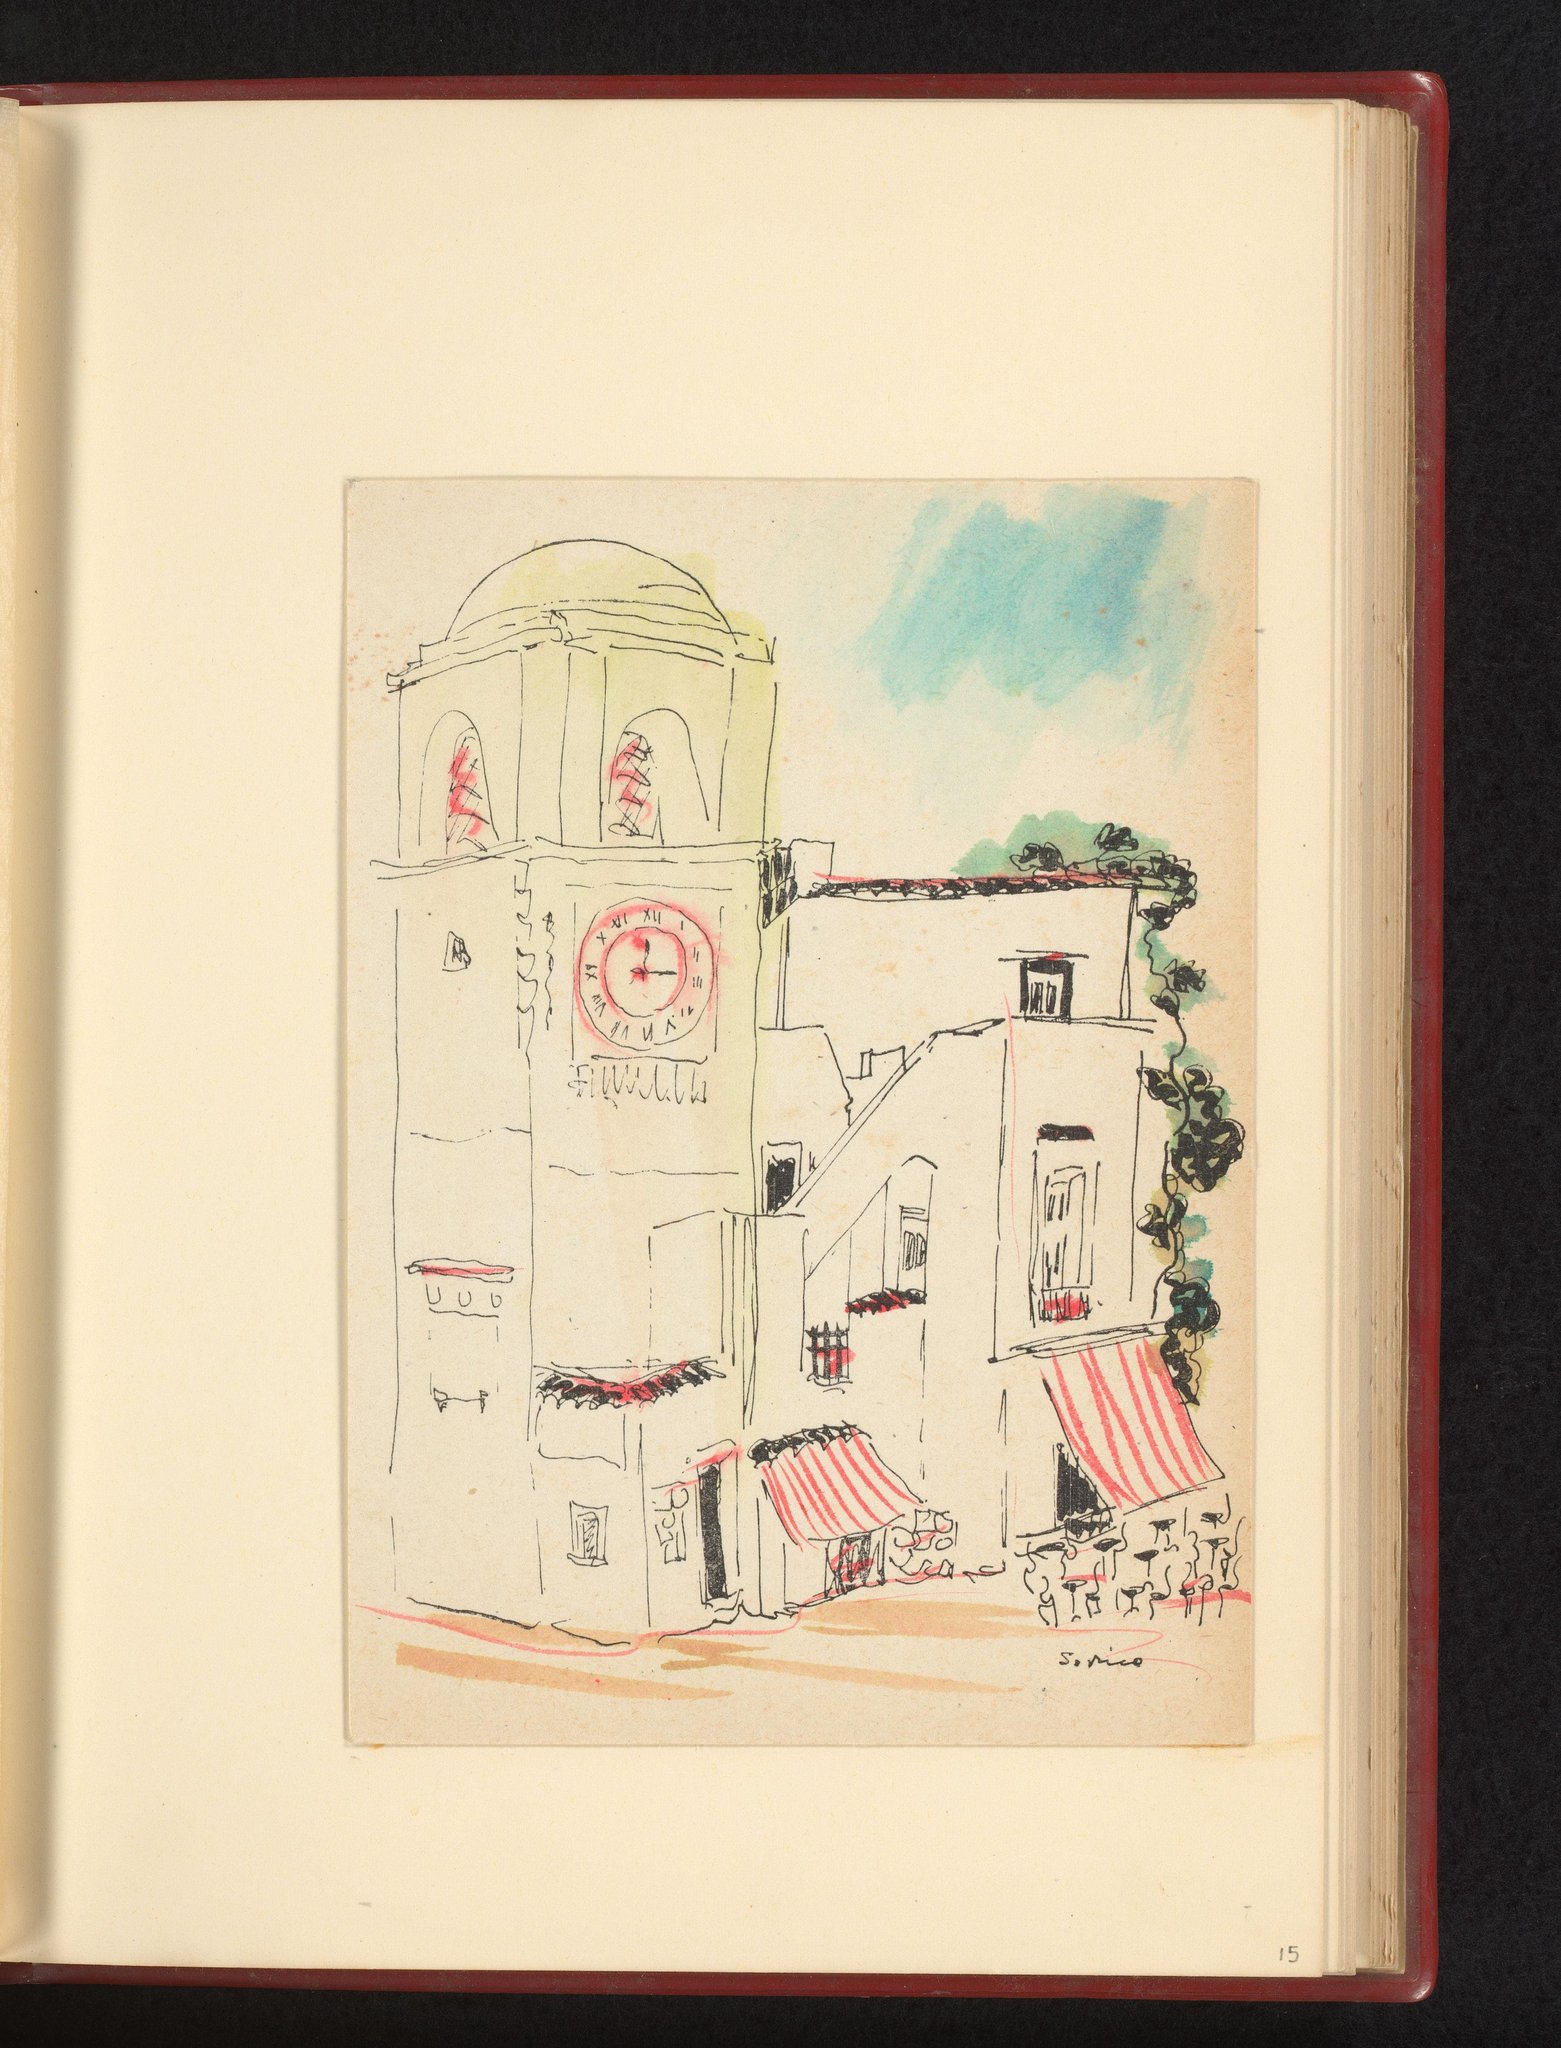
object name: album leaf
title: Fotomechanische afdruk van een tekening van een kerk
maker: Anonymous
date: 1954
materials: paper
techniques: printing block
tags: church (exterior), italy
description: Deze prent maakt deel uit van een album.